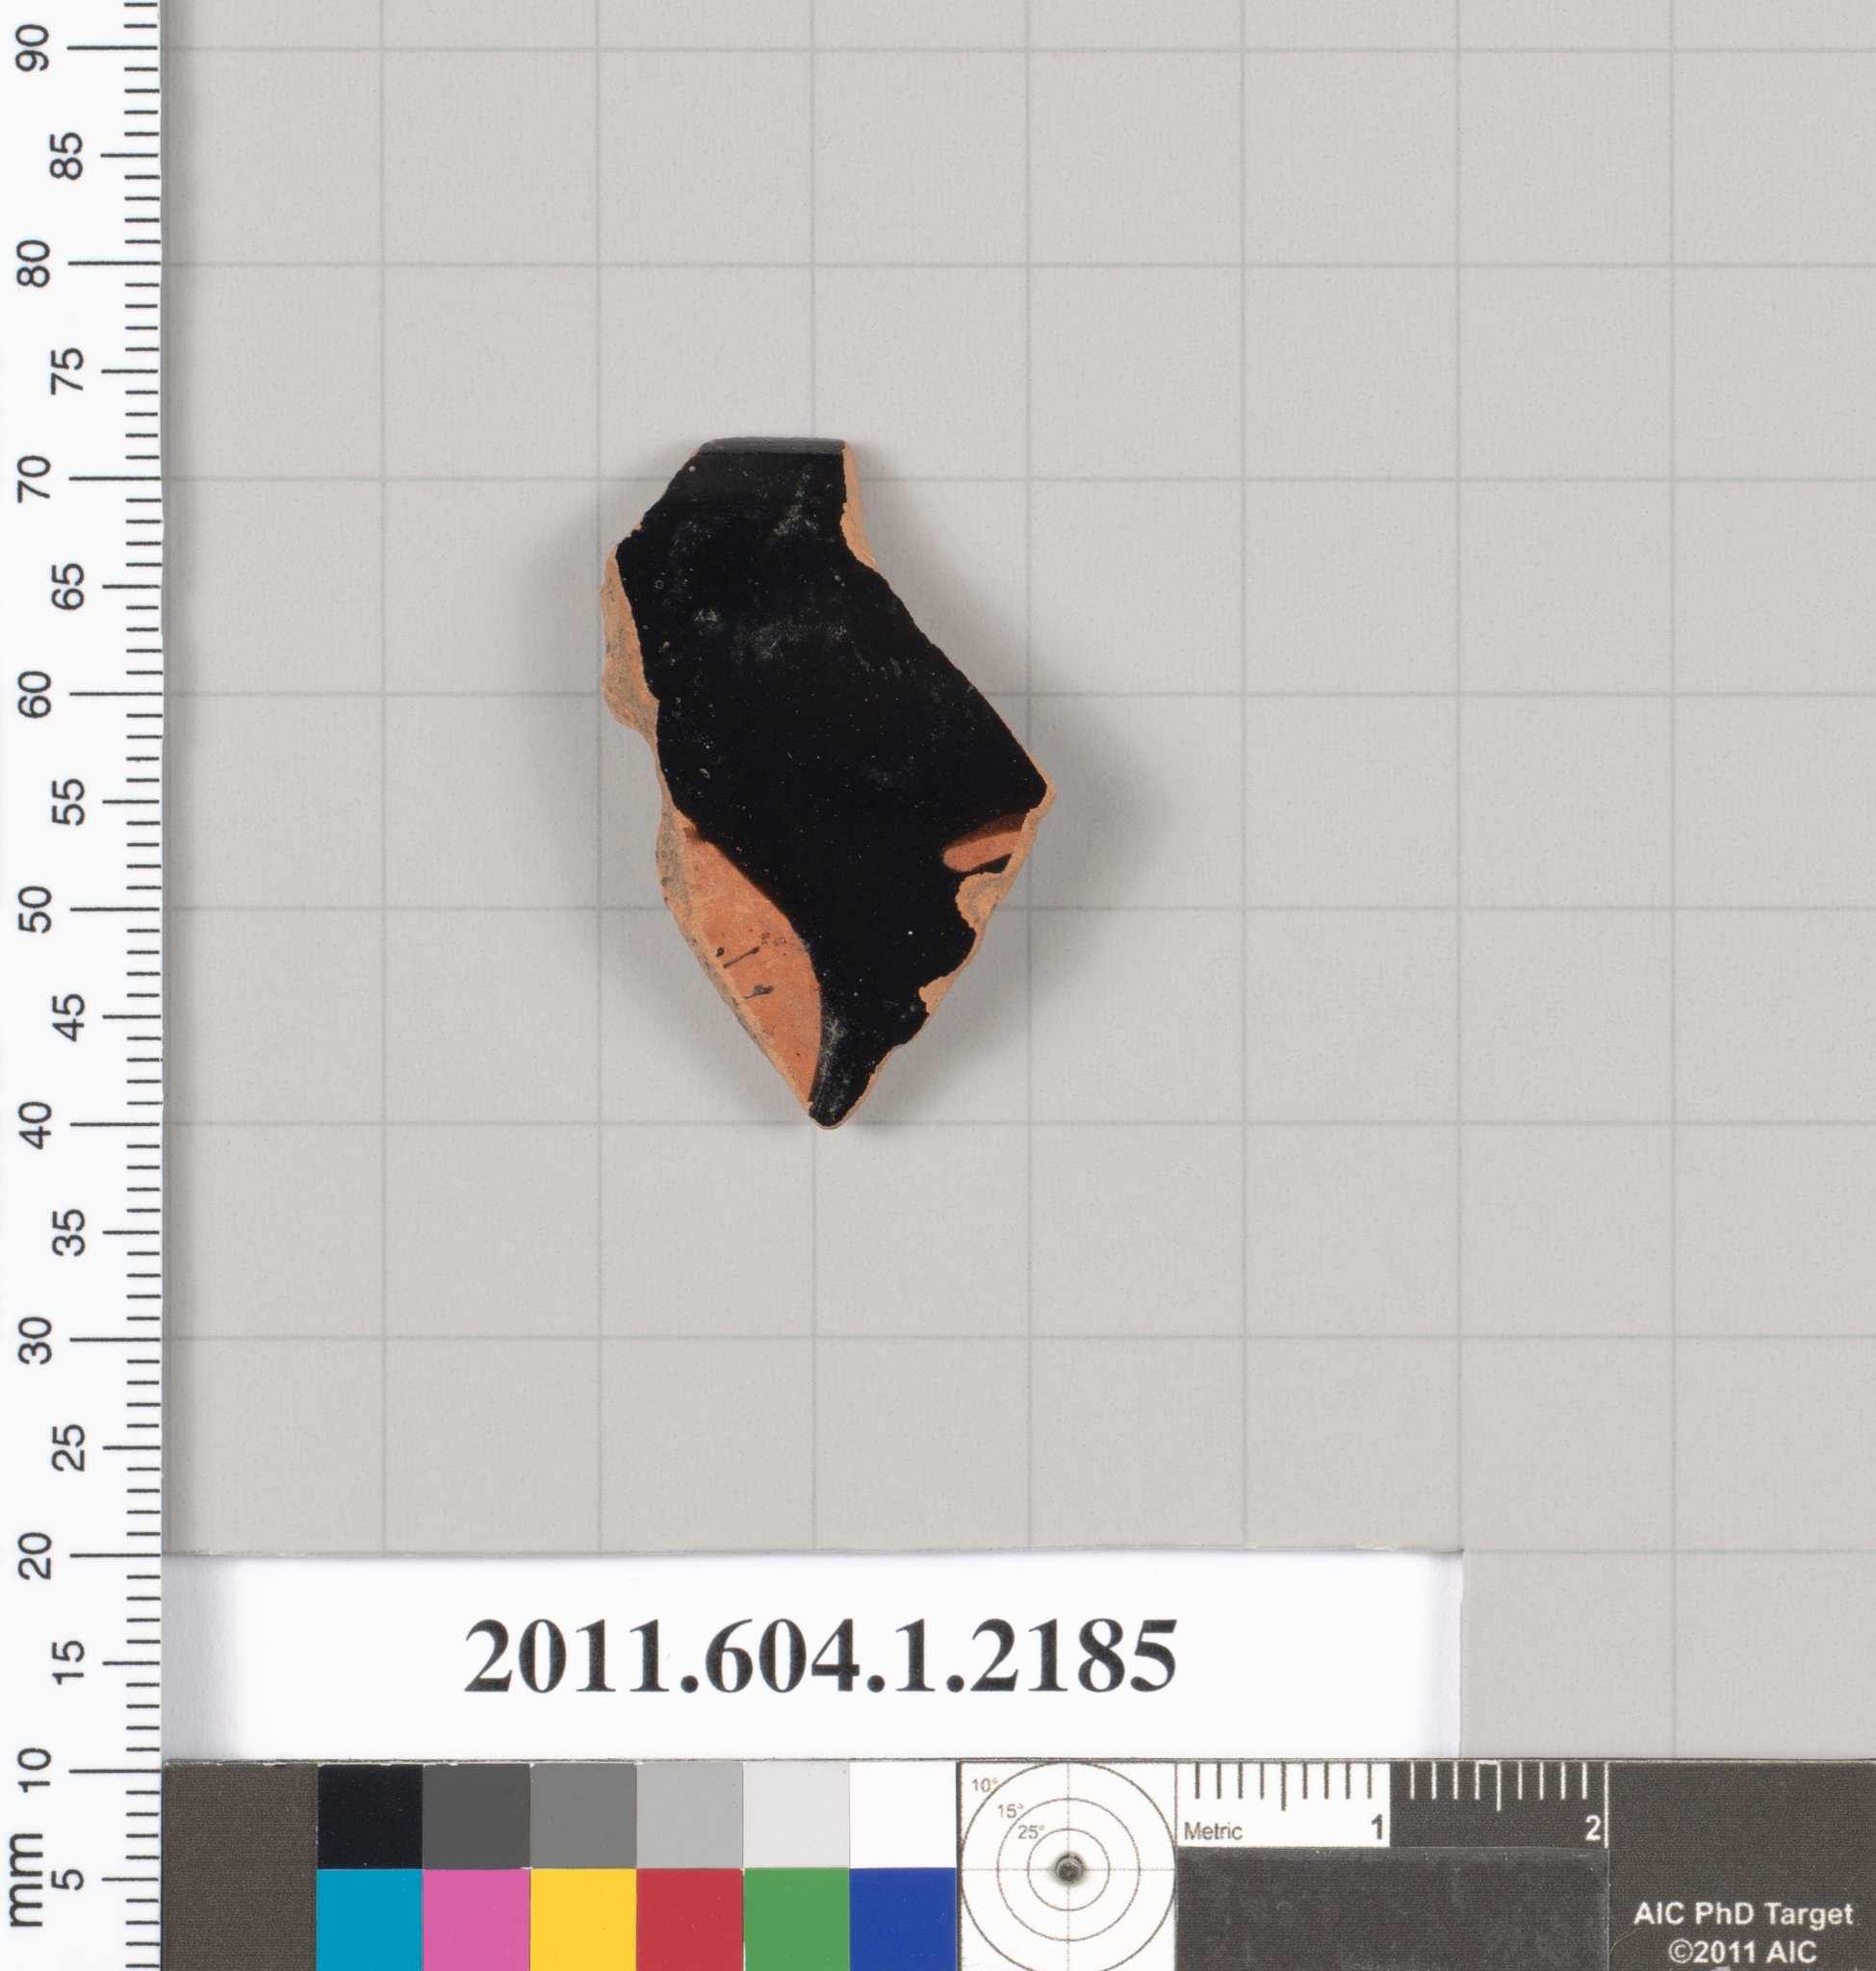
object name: kylix fragment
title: Terracotta rim fragment of a kylix (drinking cup)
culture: greek, attic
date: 467-435 BCE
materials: terracotta